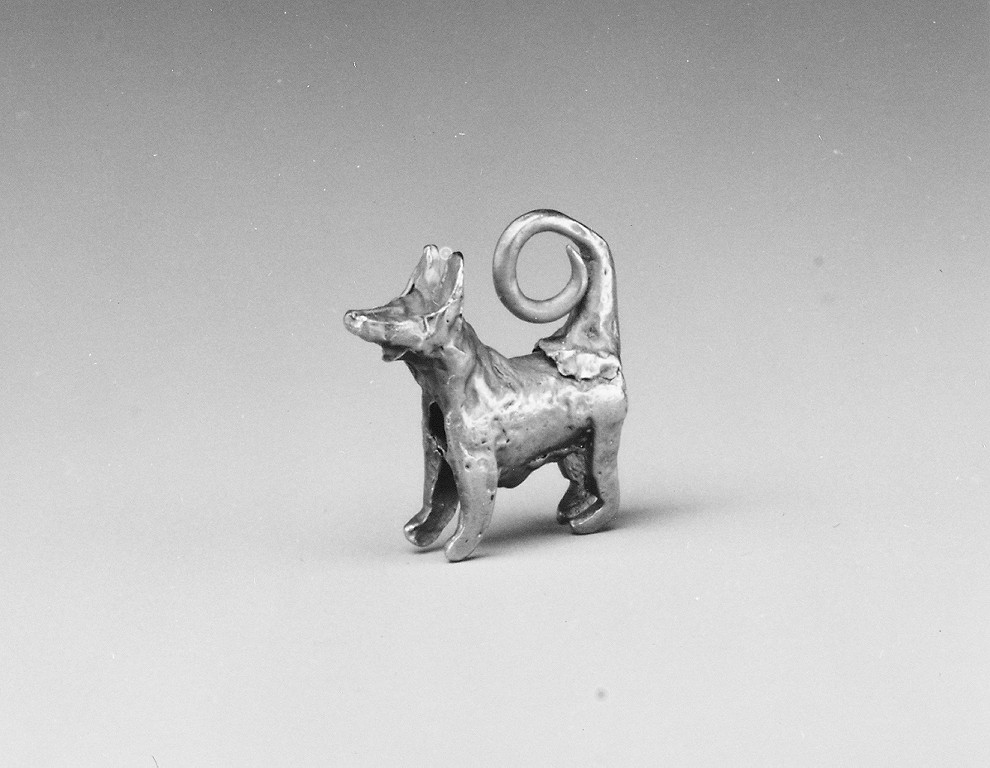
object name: pendant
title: Dog pendant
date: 3300-2900 BCE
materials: gold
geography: iran or mesopotamia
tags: dogs